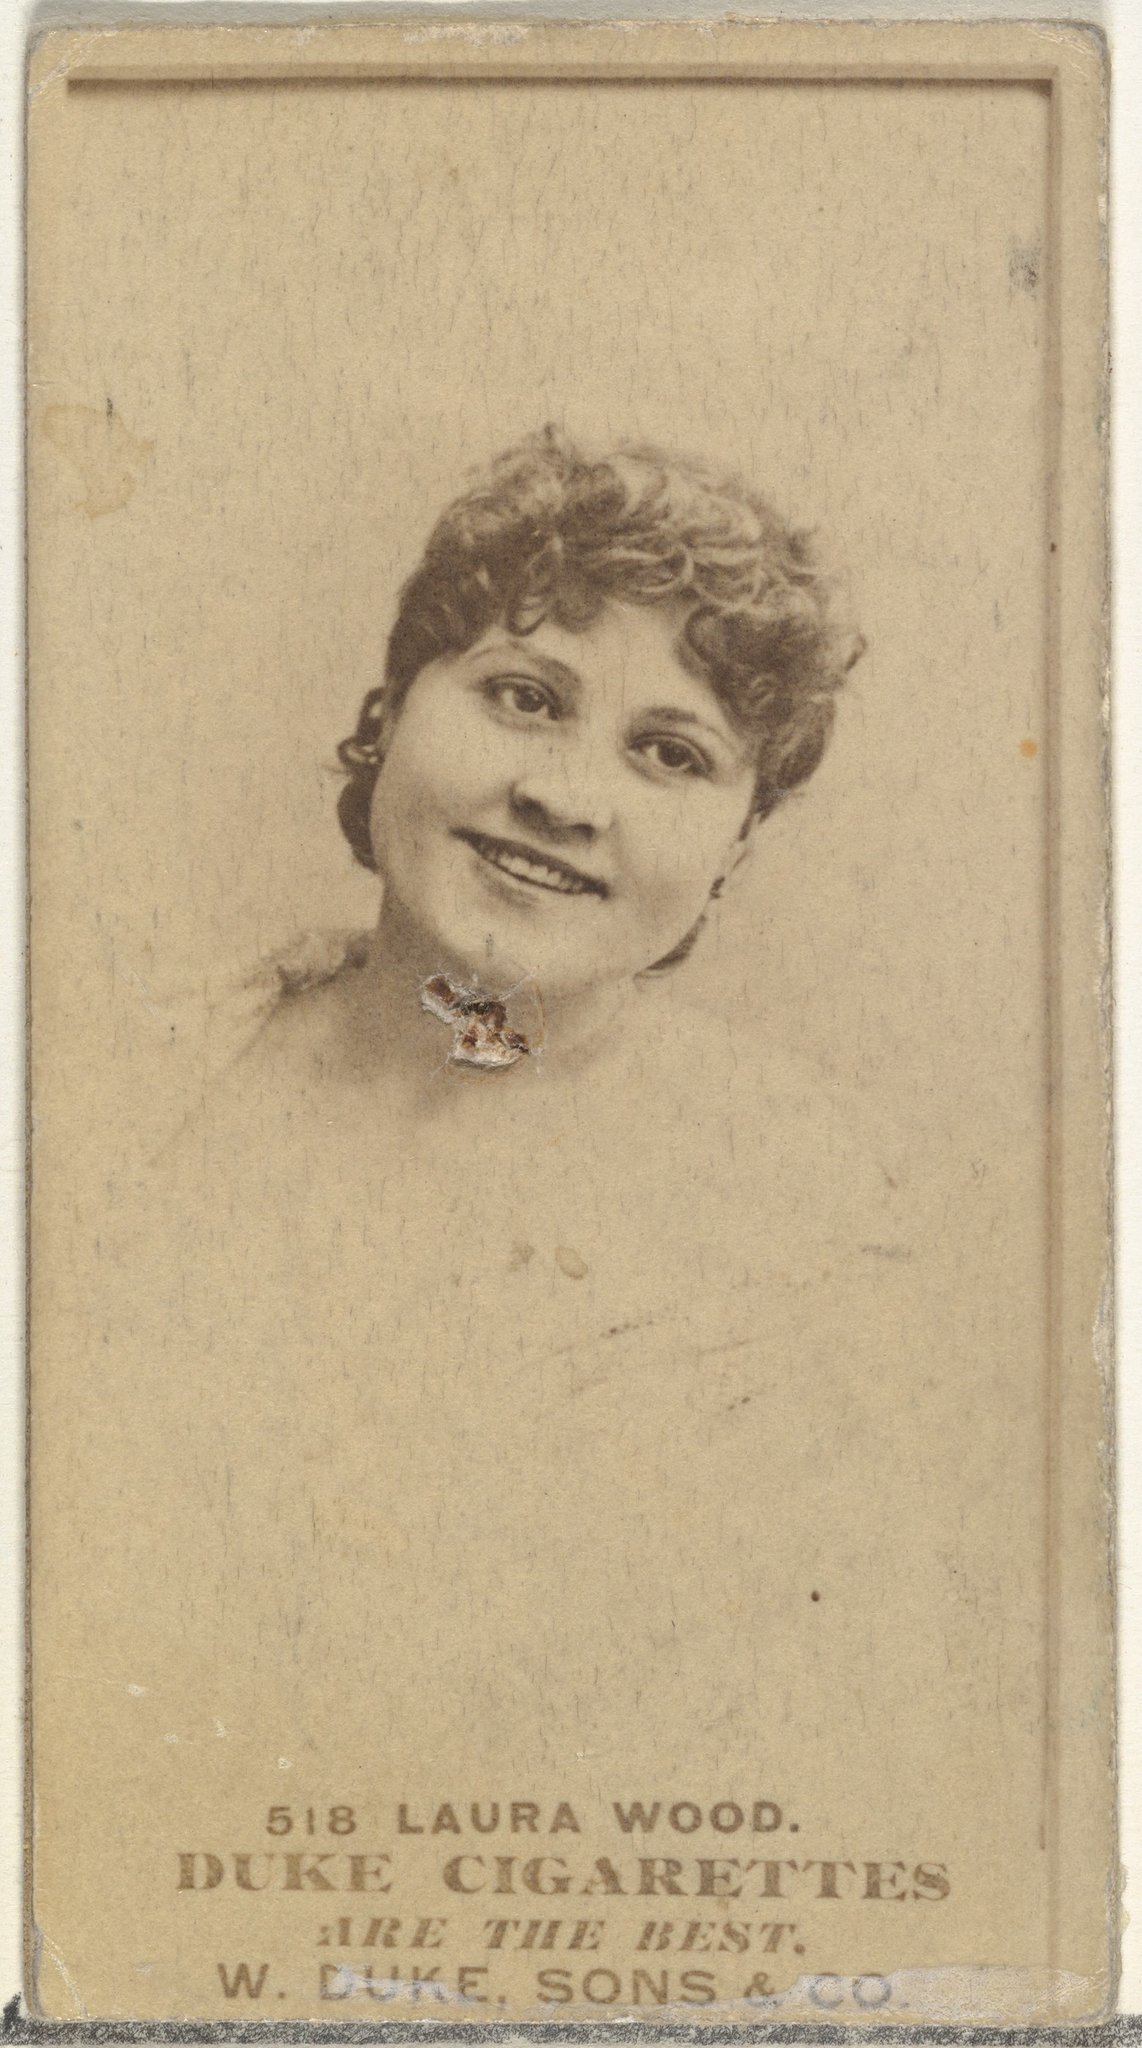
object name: photograph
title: Card Number 518, Laura Wood, from the Actors and Actresses series (N145-7) issued by Duke Sons & Co. to promote Duke Cigarettes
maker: w. duke, sons & co.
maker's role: publisher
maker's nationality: american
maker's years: 1870-1920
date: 1880-1889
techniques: albumen silver print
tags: portraits,women,actresses